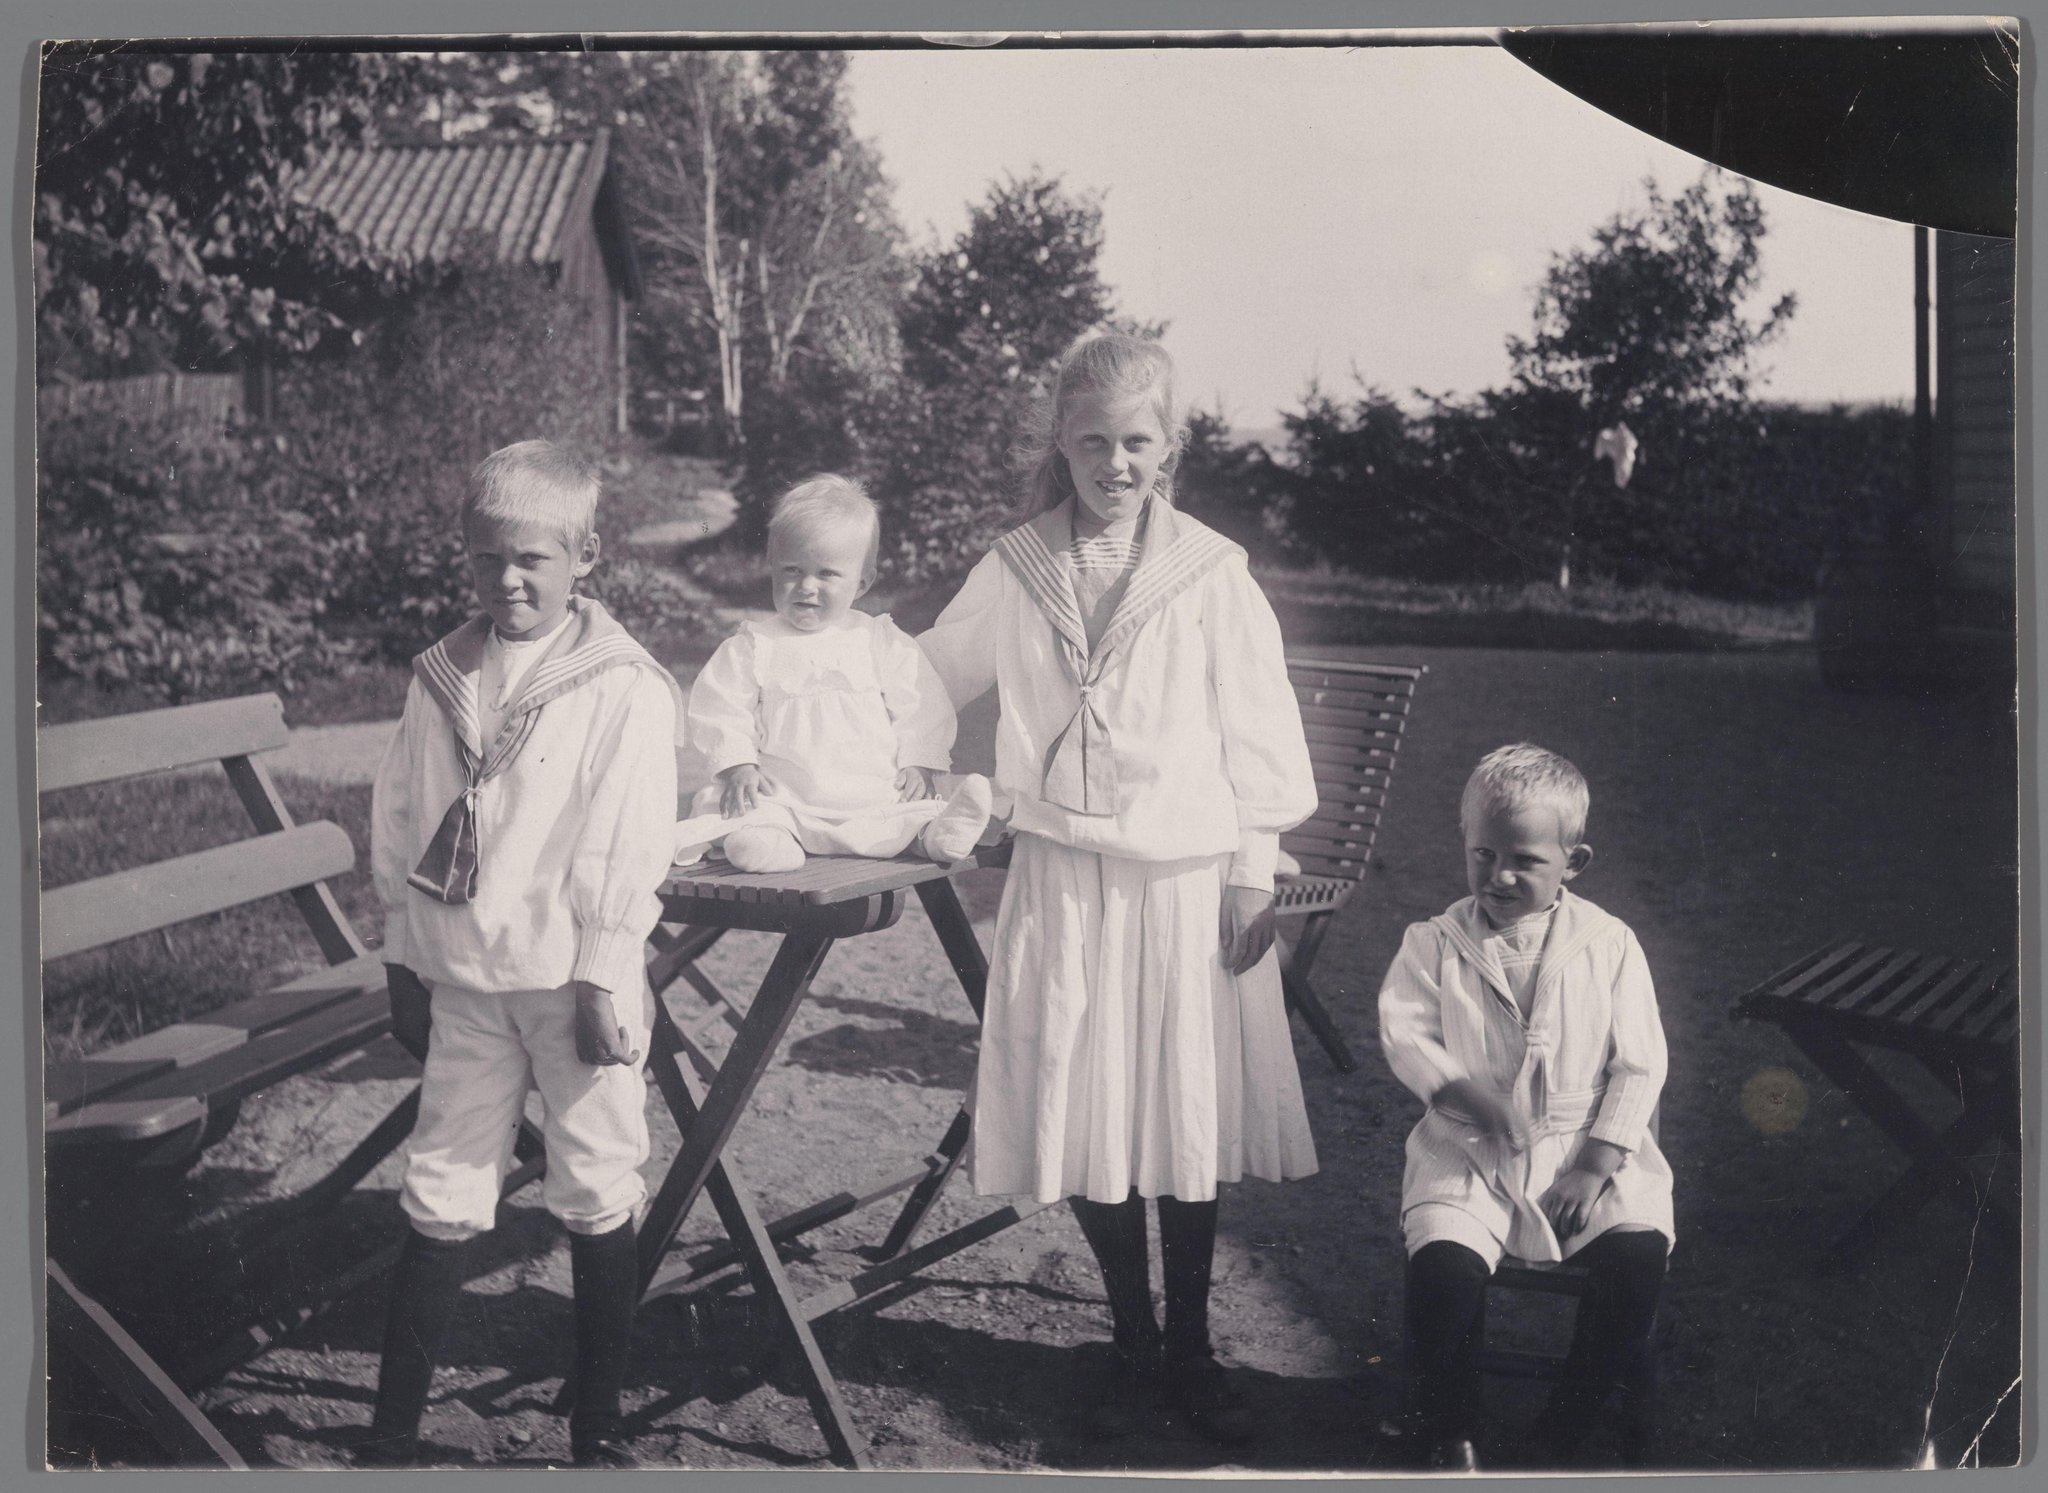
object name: photograph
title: Portret van vier onbekende kinderen in een tuin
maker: Anonymous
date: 1895-1900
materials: paper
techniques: collodion silver print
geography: netherlands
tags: anonymous historical persons portrayed in a group, in a group-portrait